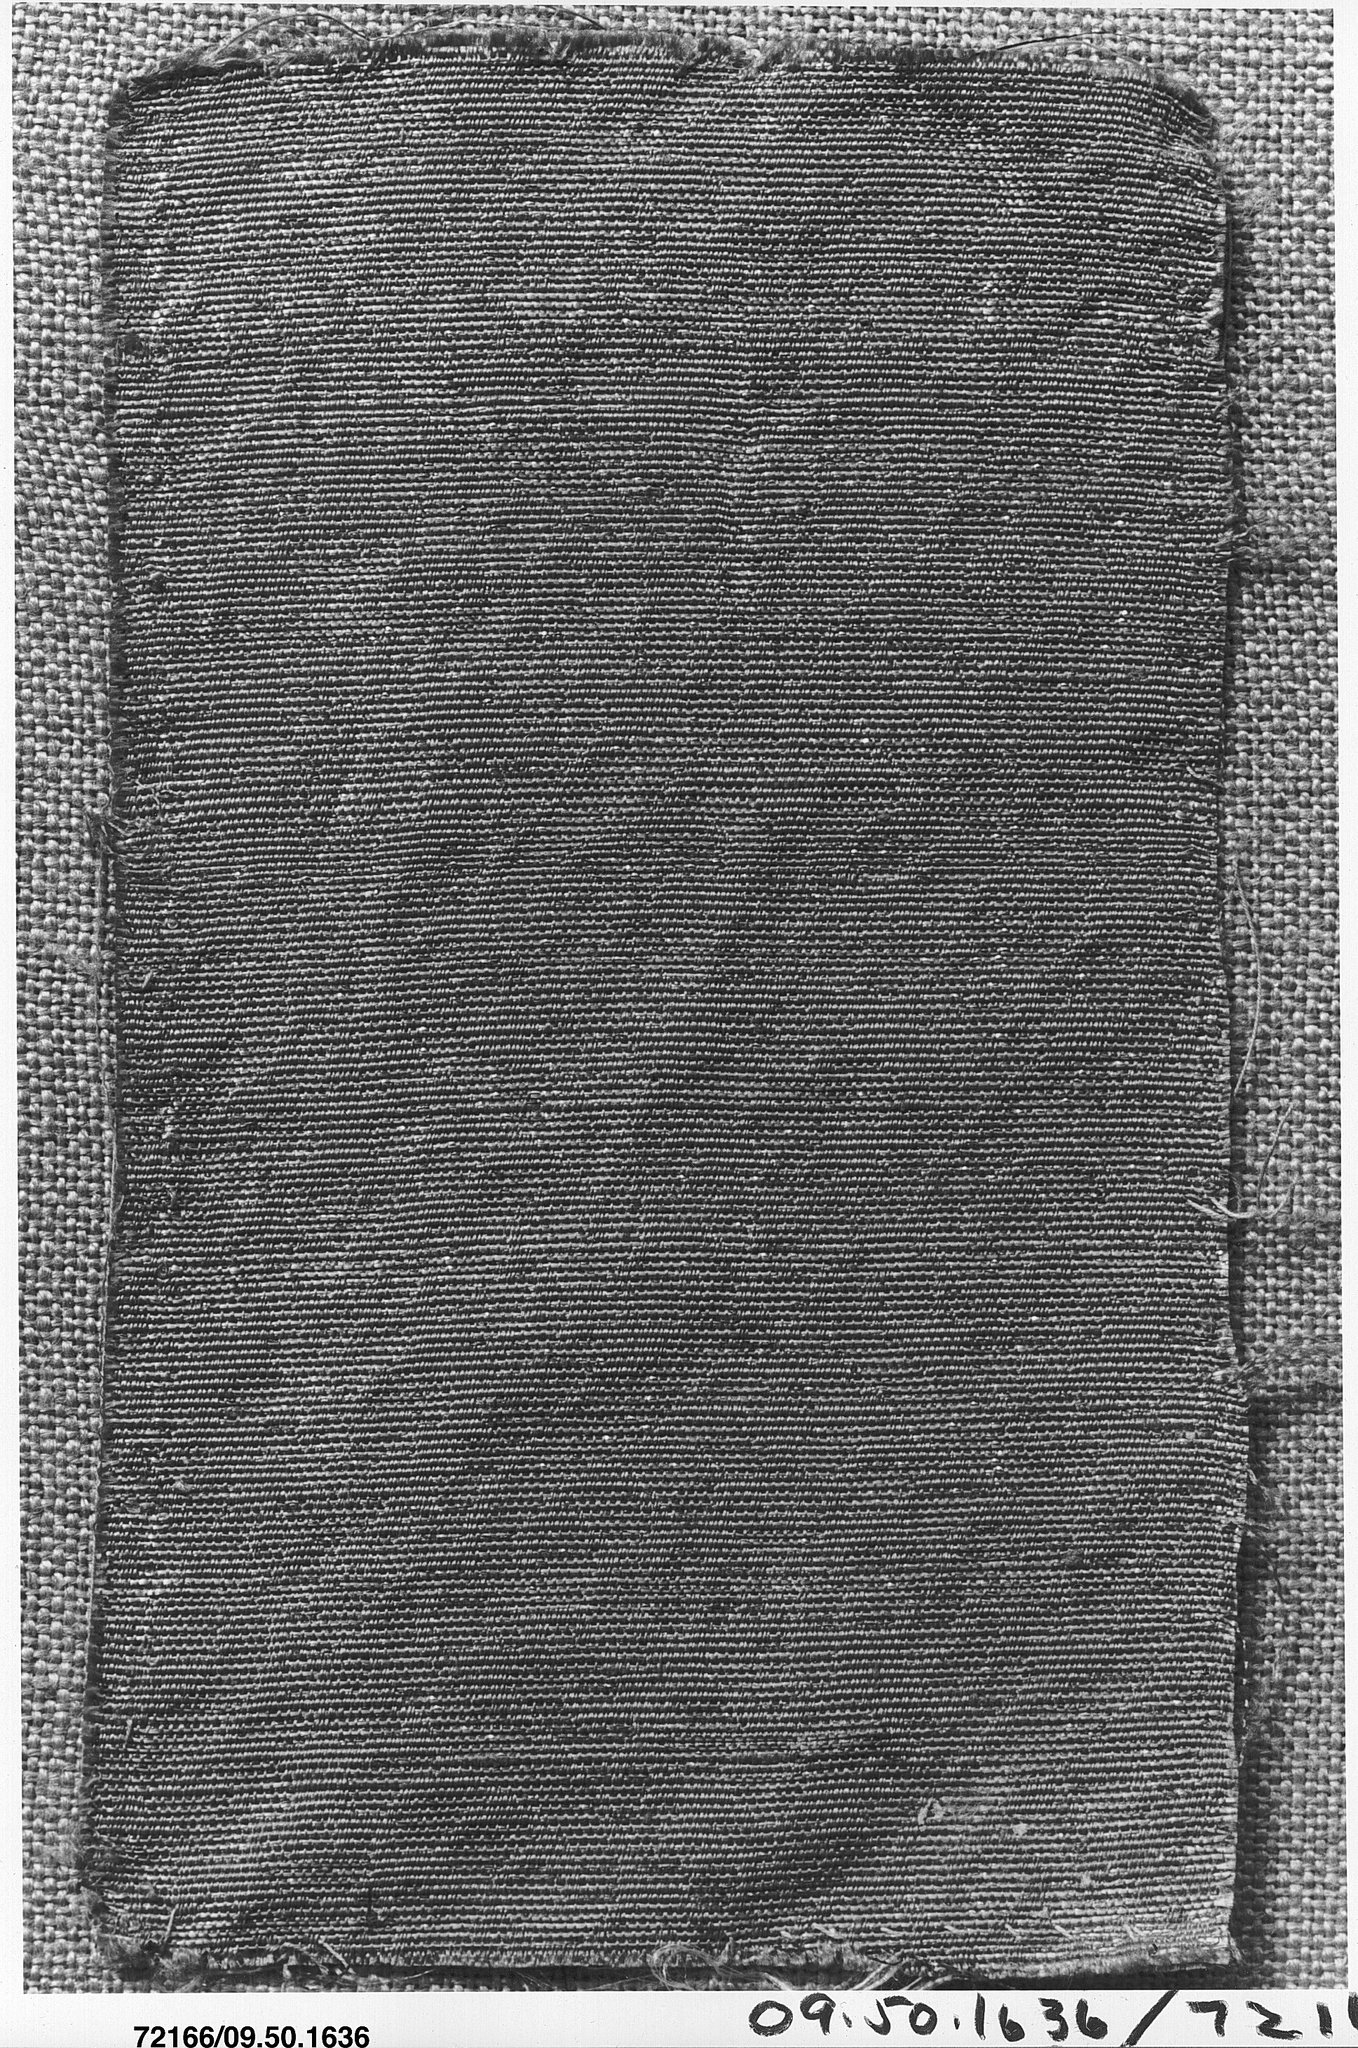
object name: piece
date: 1501-1700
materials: metal thread, silk